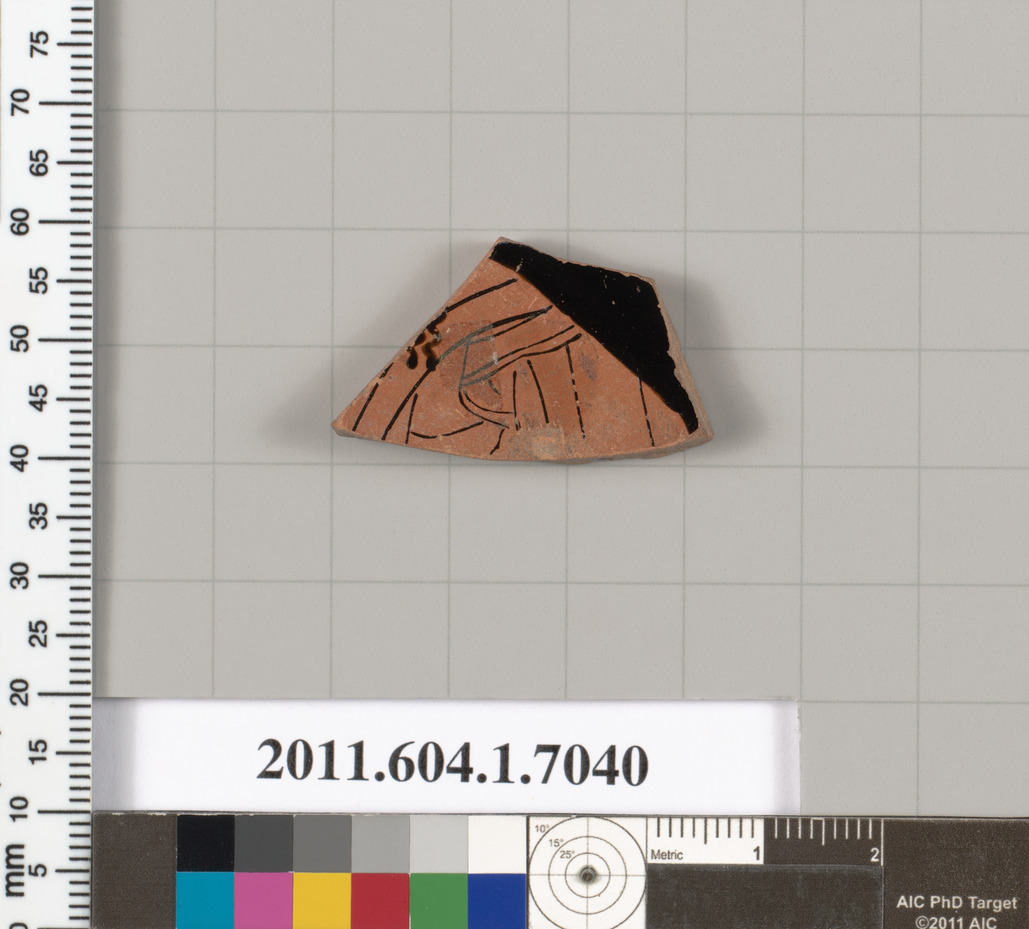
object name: kylix fragment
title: Terracotta fragment of a kylix (drinking cup)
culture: greek, attic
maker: douris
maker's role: artist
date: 500-480 BCE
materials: terracotta